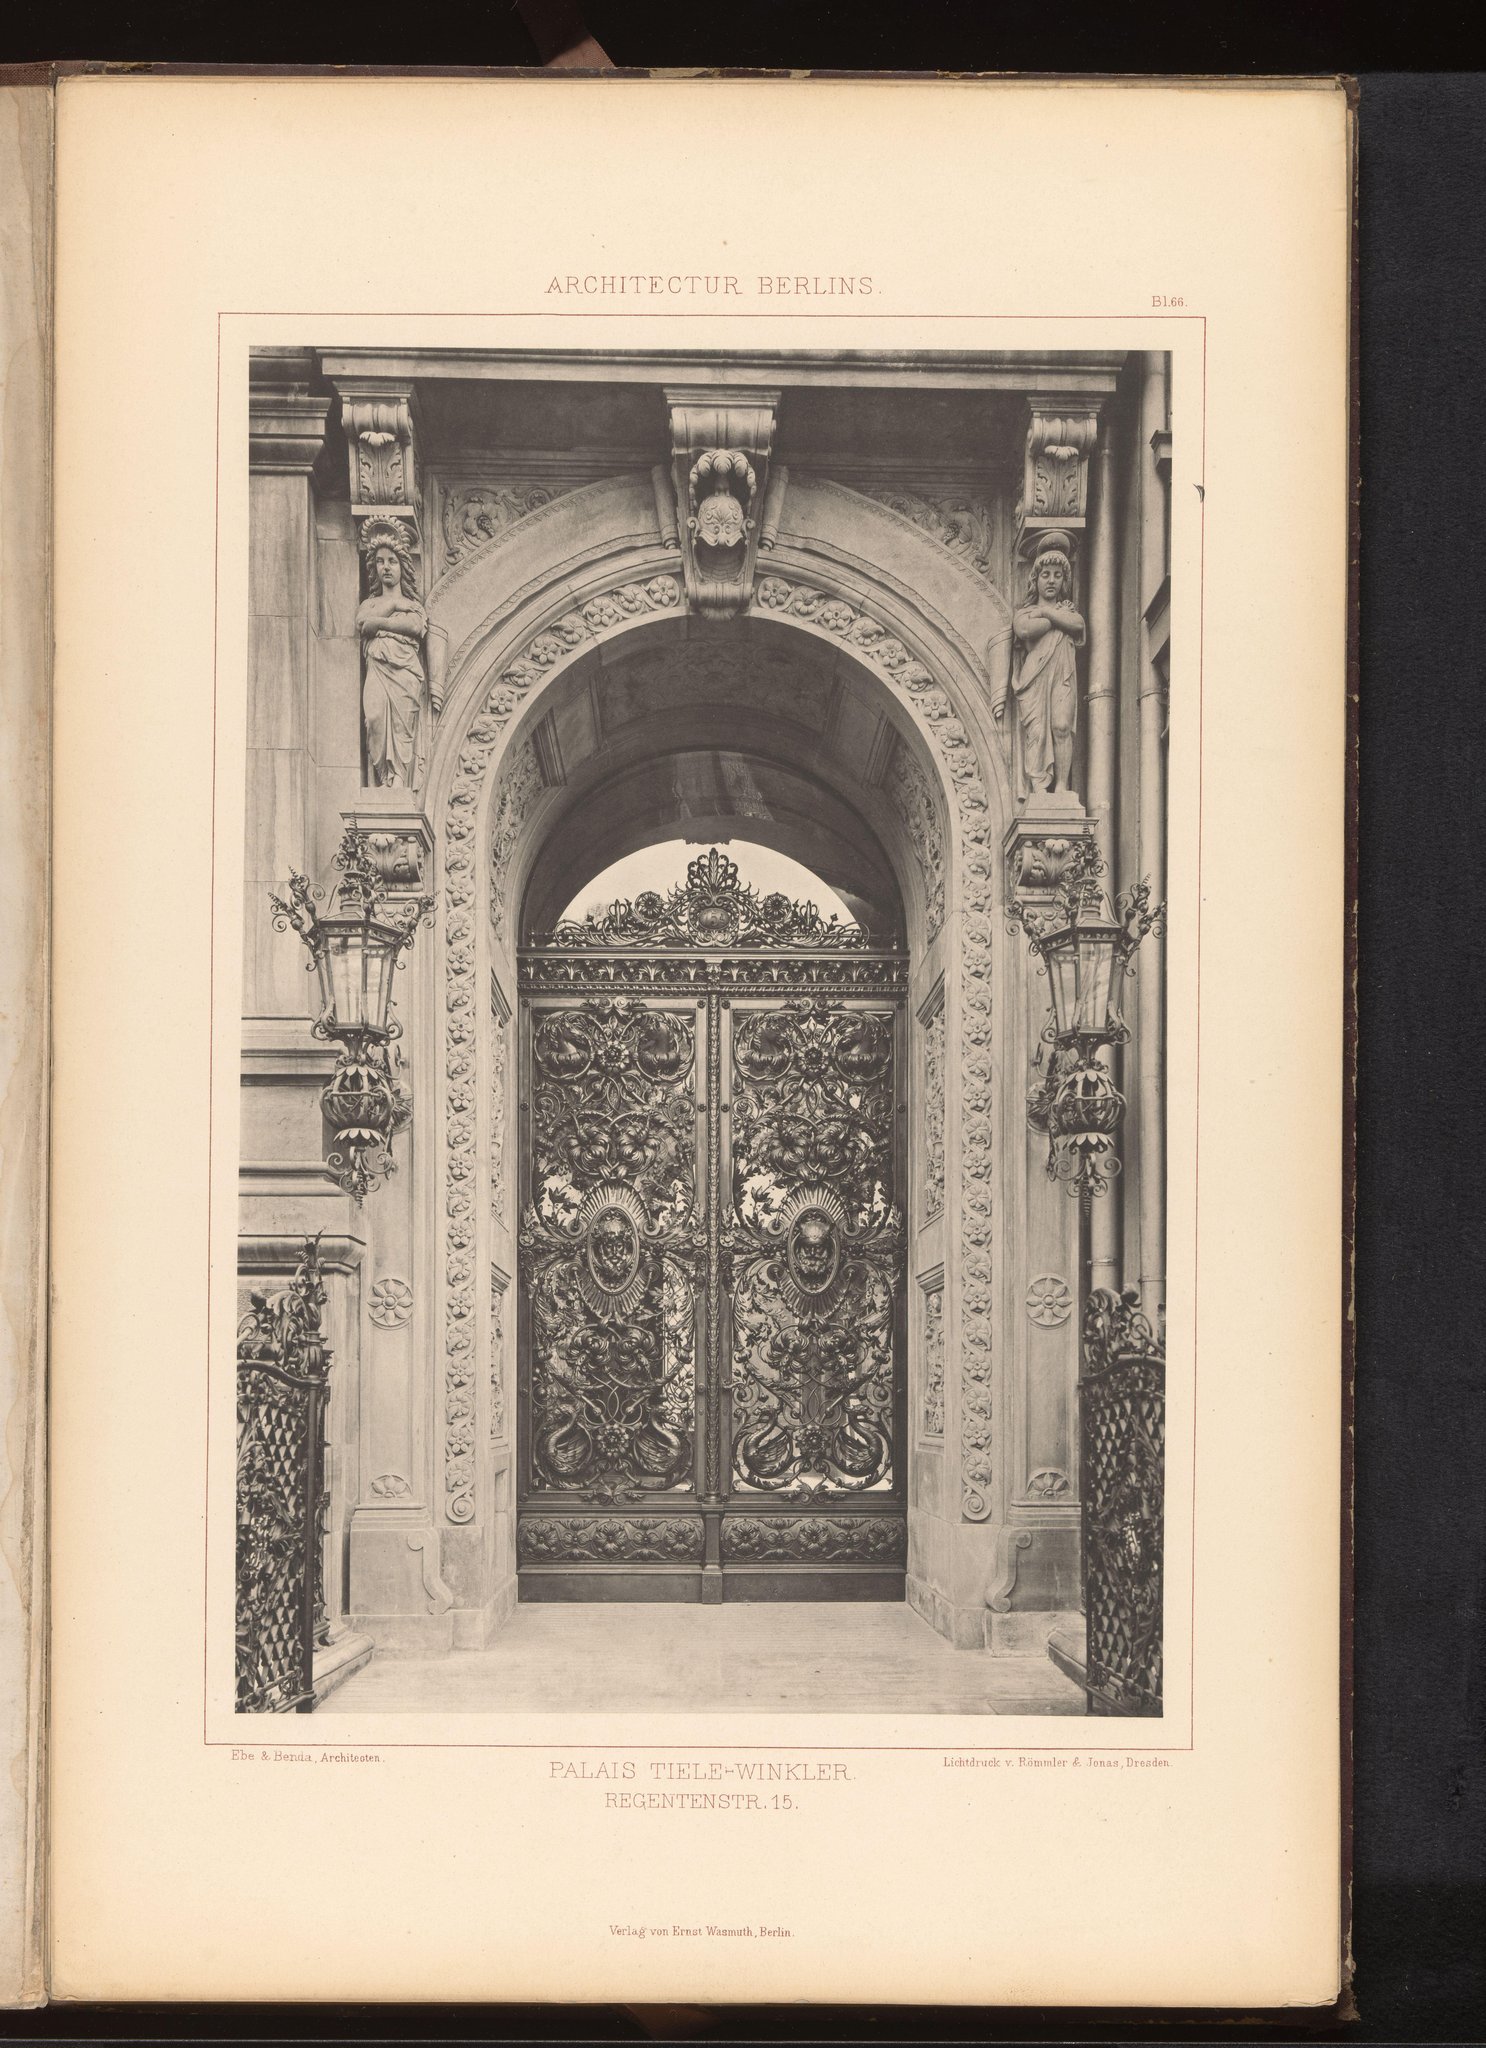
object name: photomechanical print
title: Gezicht op een deur van het Palais Tiele-Winckler aan de Regentenstrasse 15 in Berlijn, Duitsland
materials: paper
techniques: photograph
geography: berlin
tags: urban housing, closed door, berlin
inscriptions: inscription: ‘Ebe & Benda, Architecten.’, number: ‘Bl. 66.’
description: Deze prent maakt deel uit van een omslag met honderd prenten en zes tekstbladen.